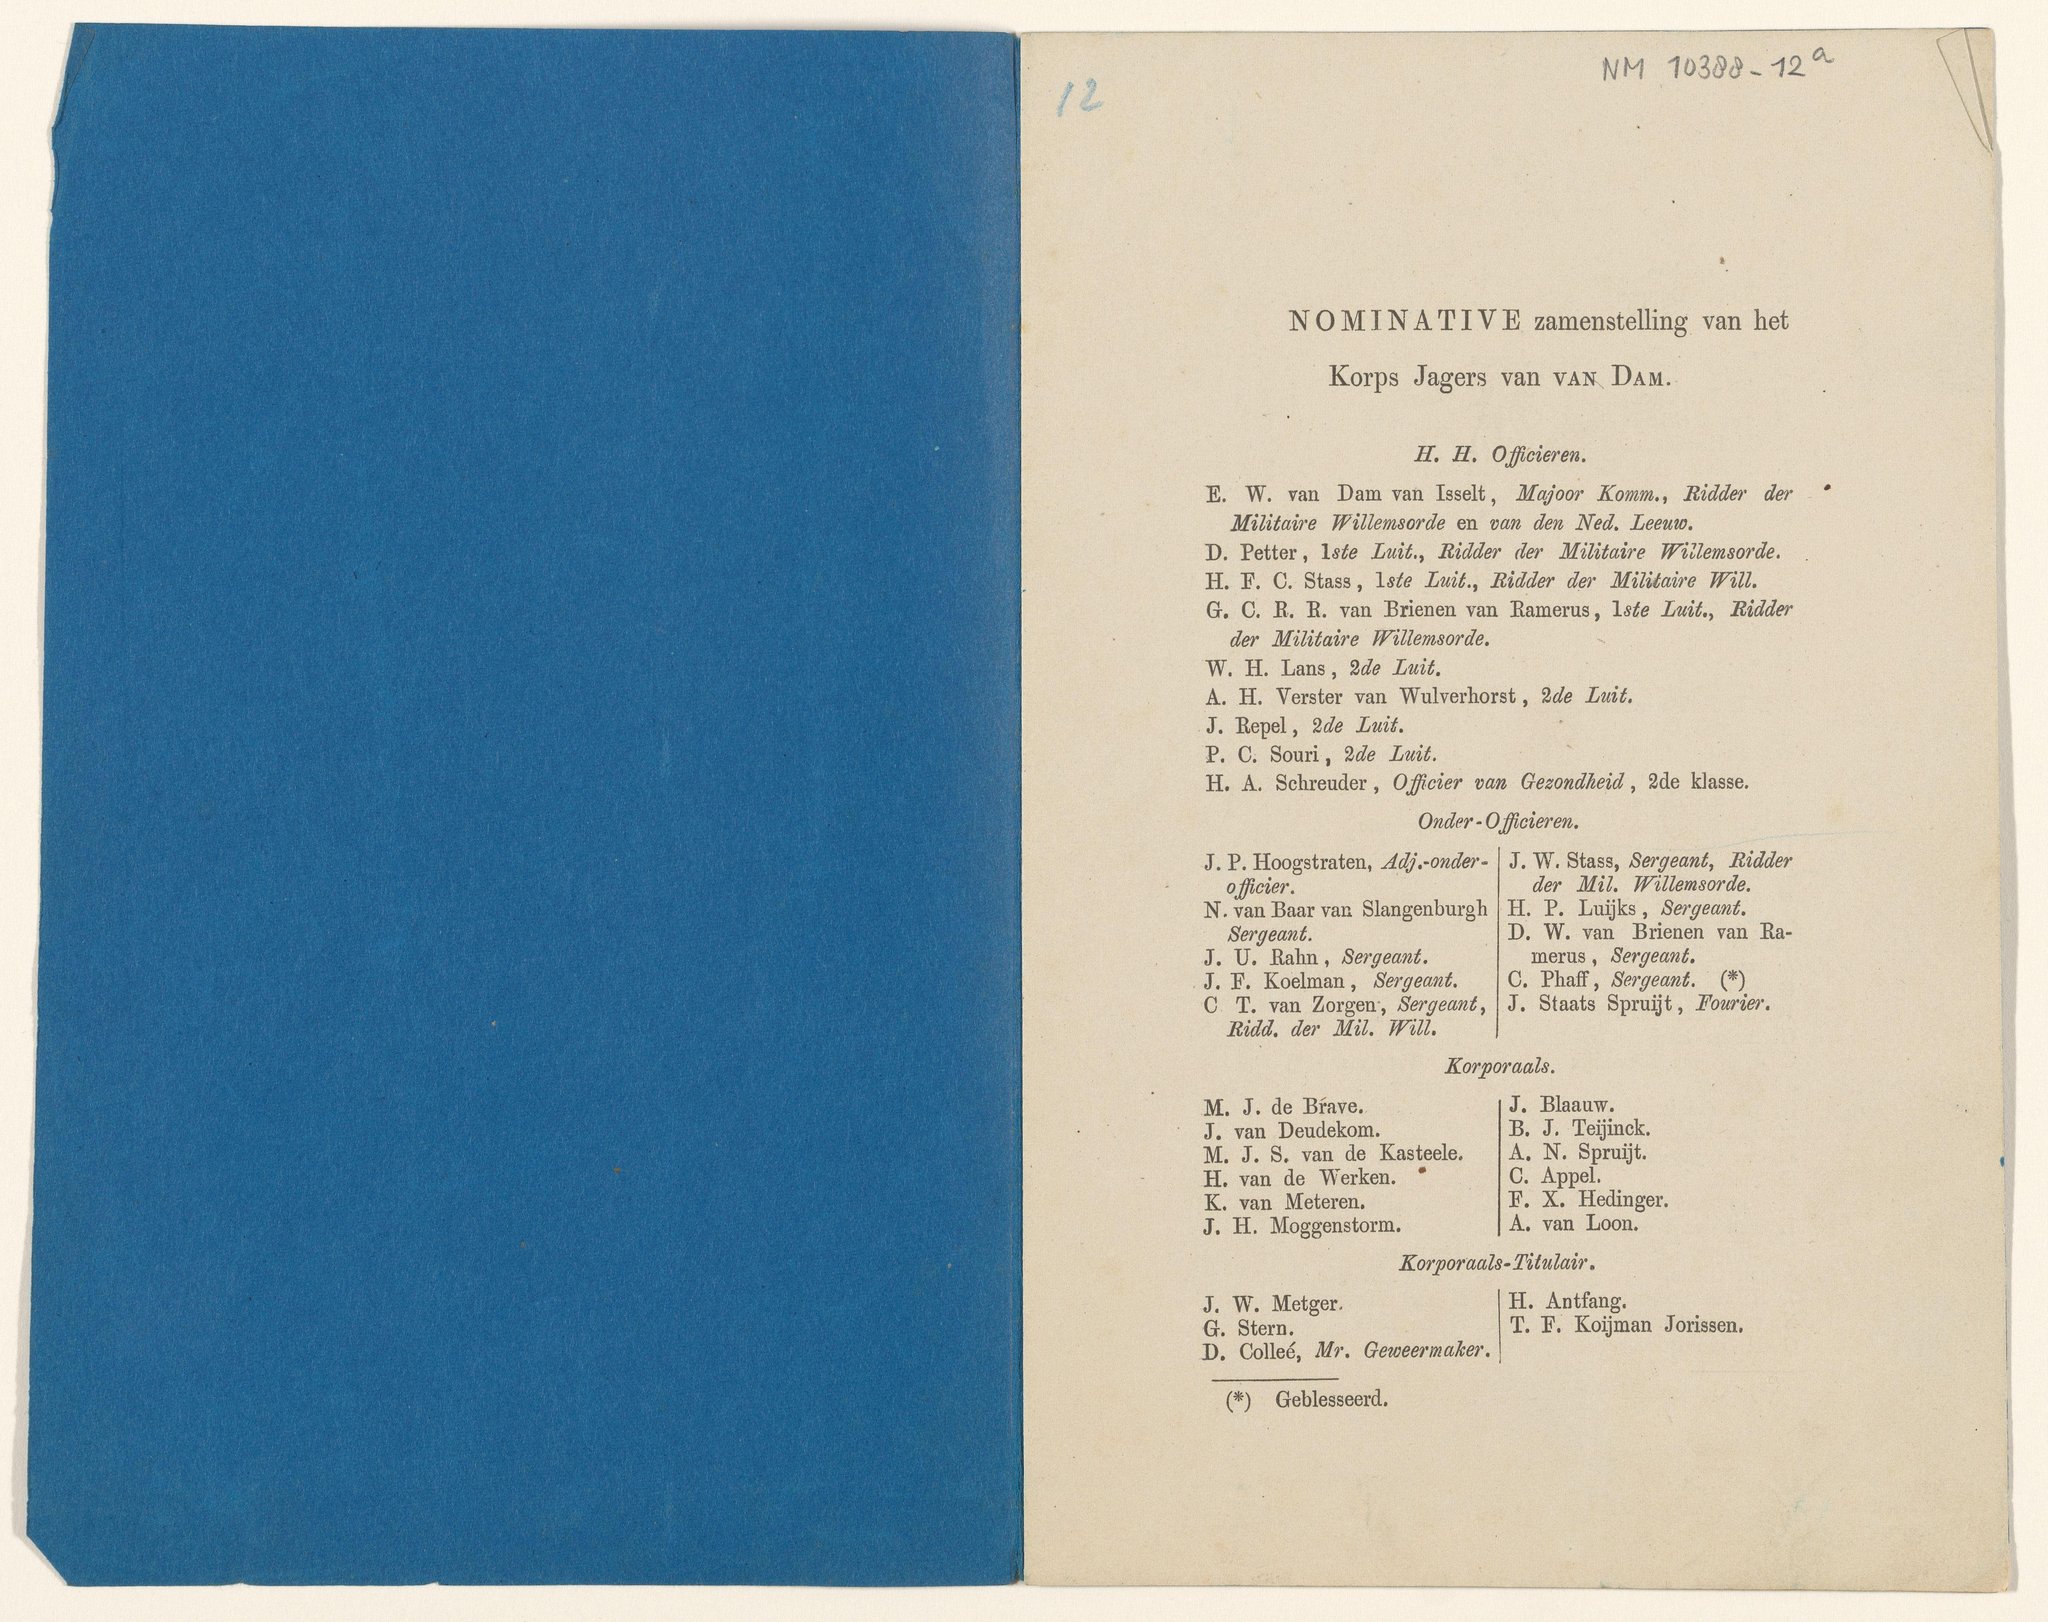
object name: brochure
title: Nominatieve zamenstelling van het Korps Jagers van VAN DAM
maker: a. van loon (19e eeuw)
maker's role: printer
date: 1868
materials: ink, paper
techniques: printing, writing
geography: tiel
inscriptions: date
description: Brochure in blauwe papieren omslag, 4 pp met namenlijst, p. 4, met de hand '253 man = geheele sterkte, 2 man gesneuveld, 10 man geblesseerd'. Gedateerd; p.4, o.: 1868.